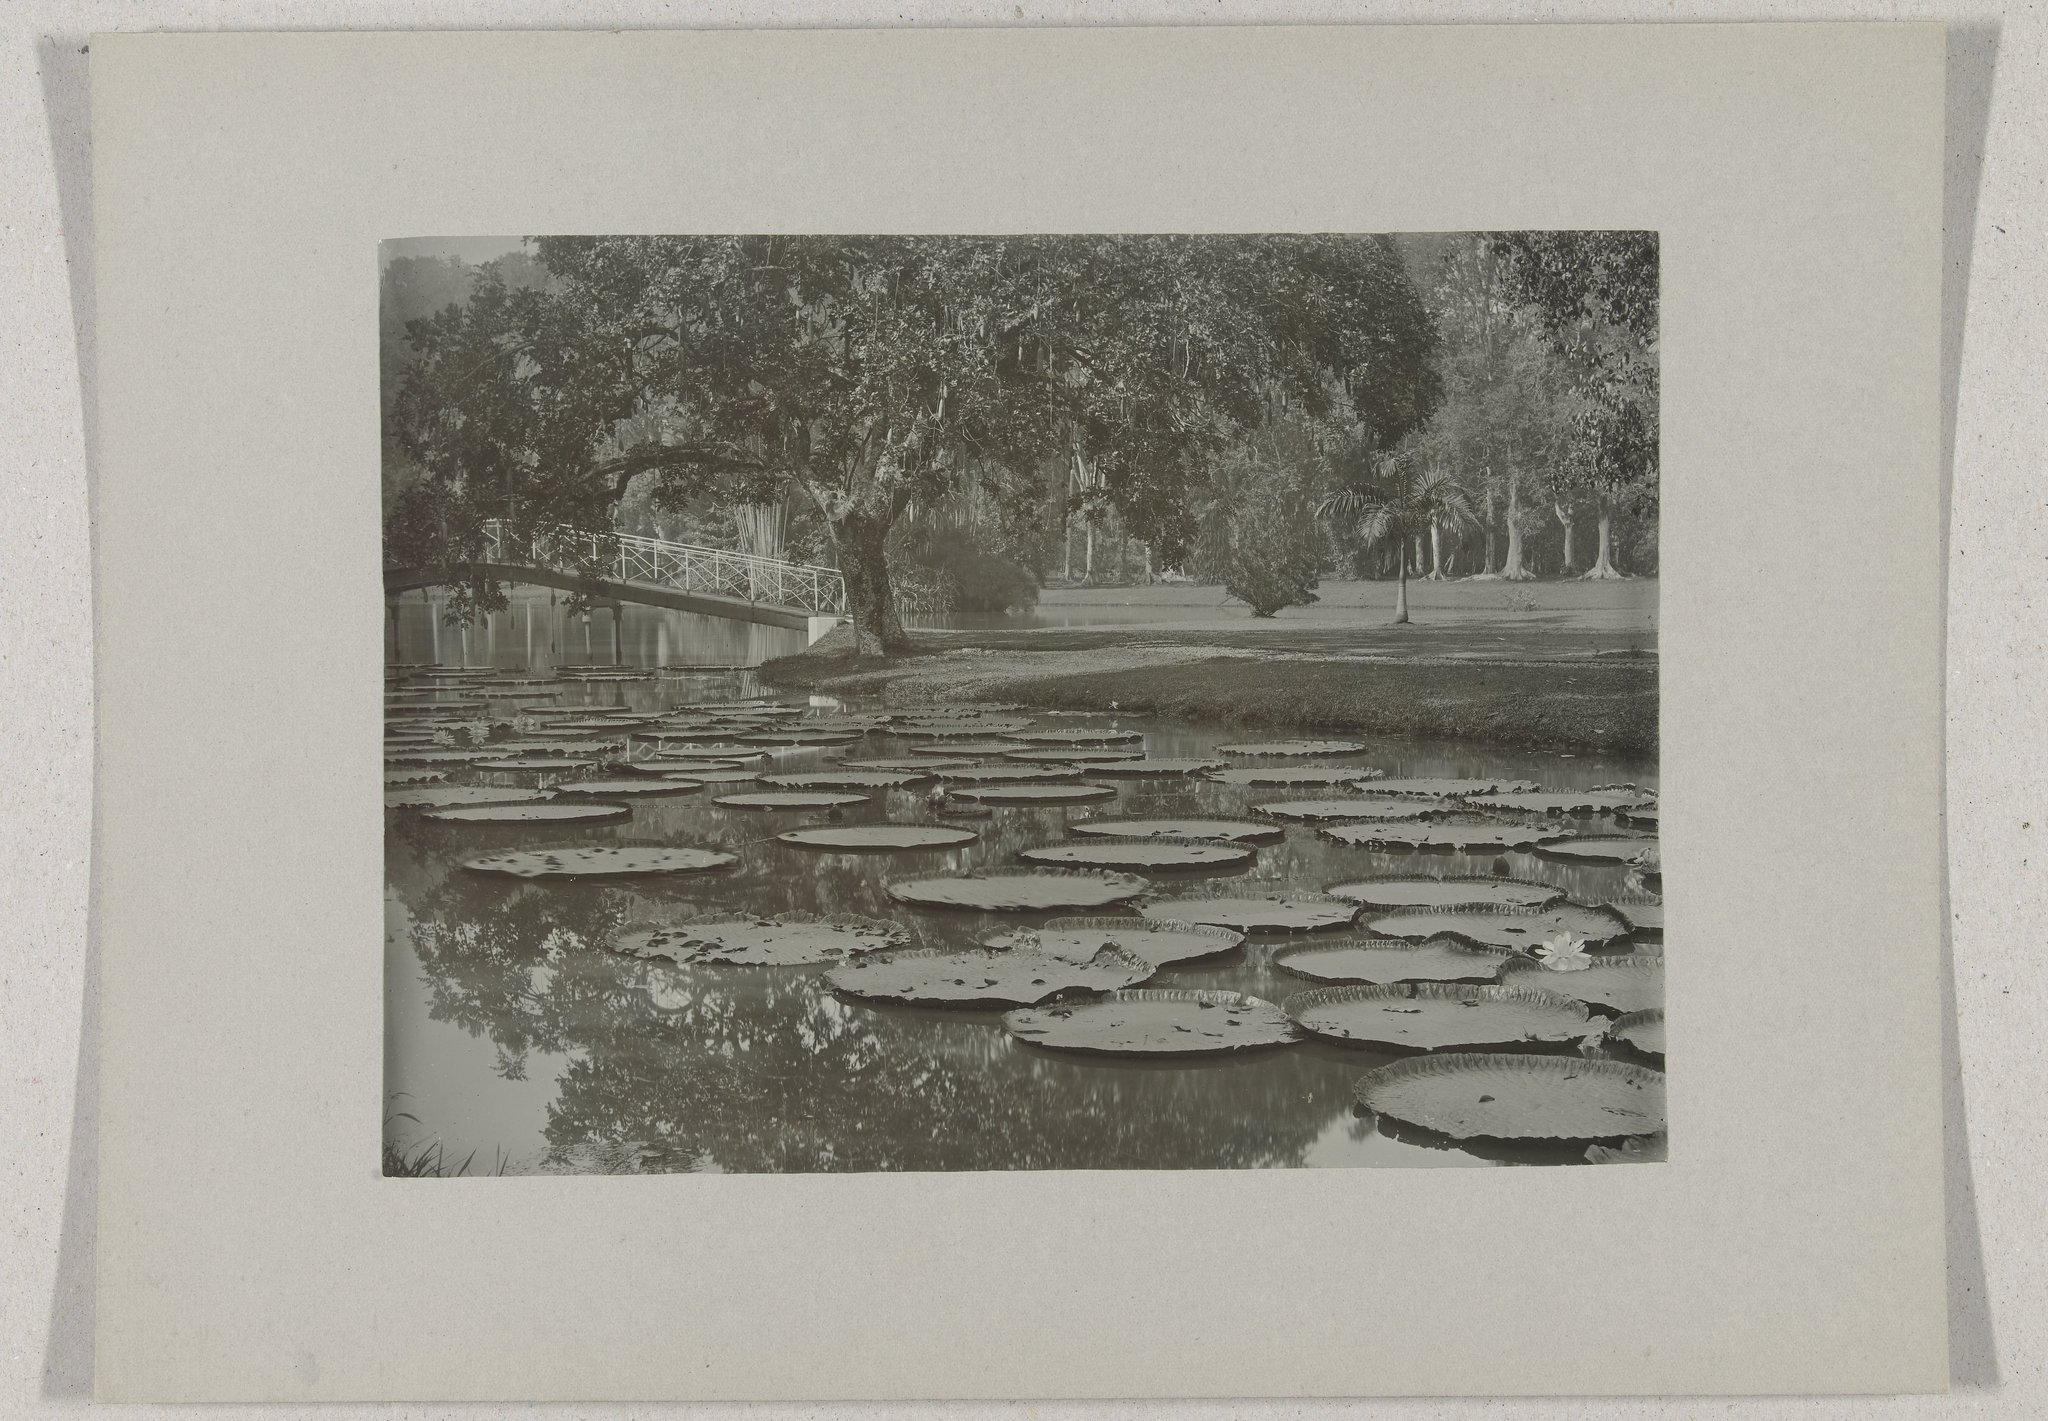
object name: photograph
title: 51. Buitenzorg: Plantentuin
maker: Anonymous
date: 1895-1915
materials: cardboard, paper, photographic support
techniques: gelatin silver print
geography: buitenzorg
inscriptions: annotation: ‘51. Buitenzorg: Plantentuin’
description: De Victoria Regia vijver in de botanische tuin te Buitenzorg (Bogor), Nederlands-Indië.